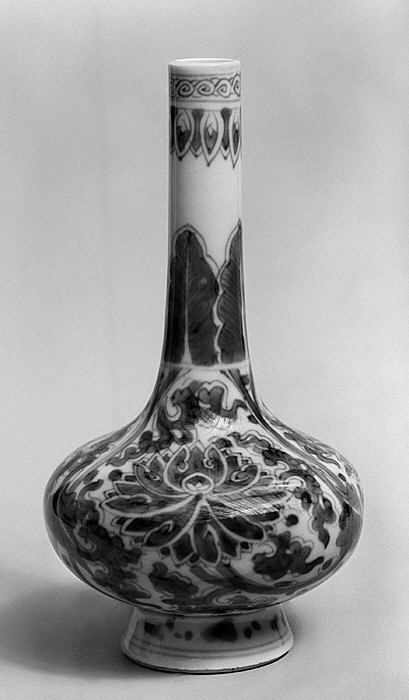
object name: bottle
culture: chinese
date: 1662-1722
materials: porcelain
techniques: underglaze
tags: flowers,leaves